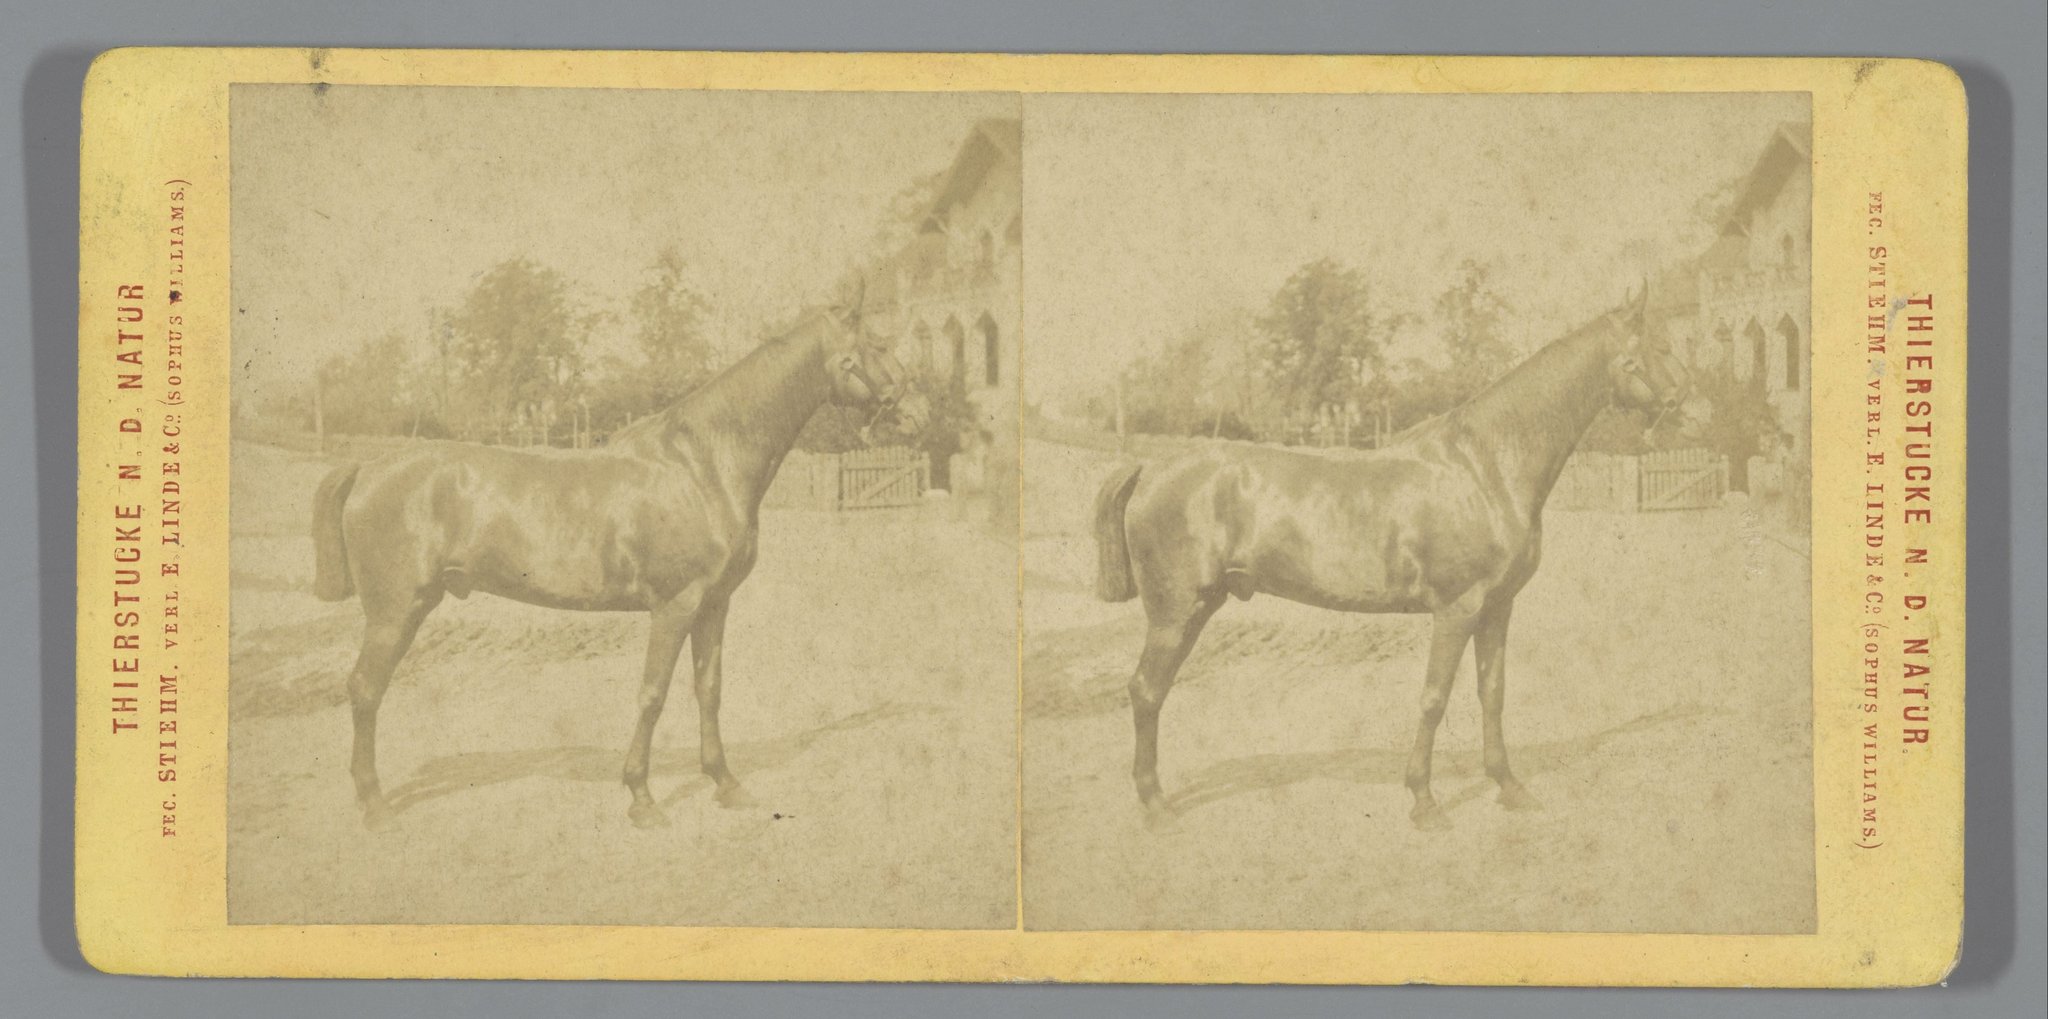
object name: stereograph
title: Thierstücke n.d. Natur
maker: johann friedrich stiehm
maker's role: fotograaf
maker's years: 1826-1902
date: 1855-1890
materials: cardboard, photographic support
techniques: albumen print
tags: horse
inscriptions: : ‘C’